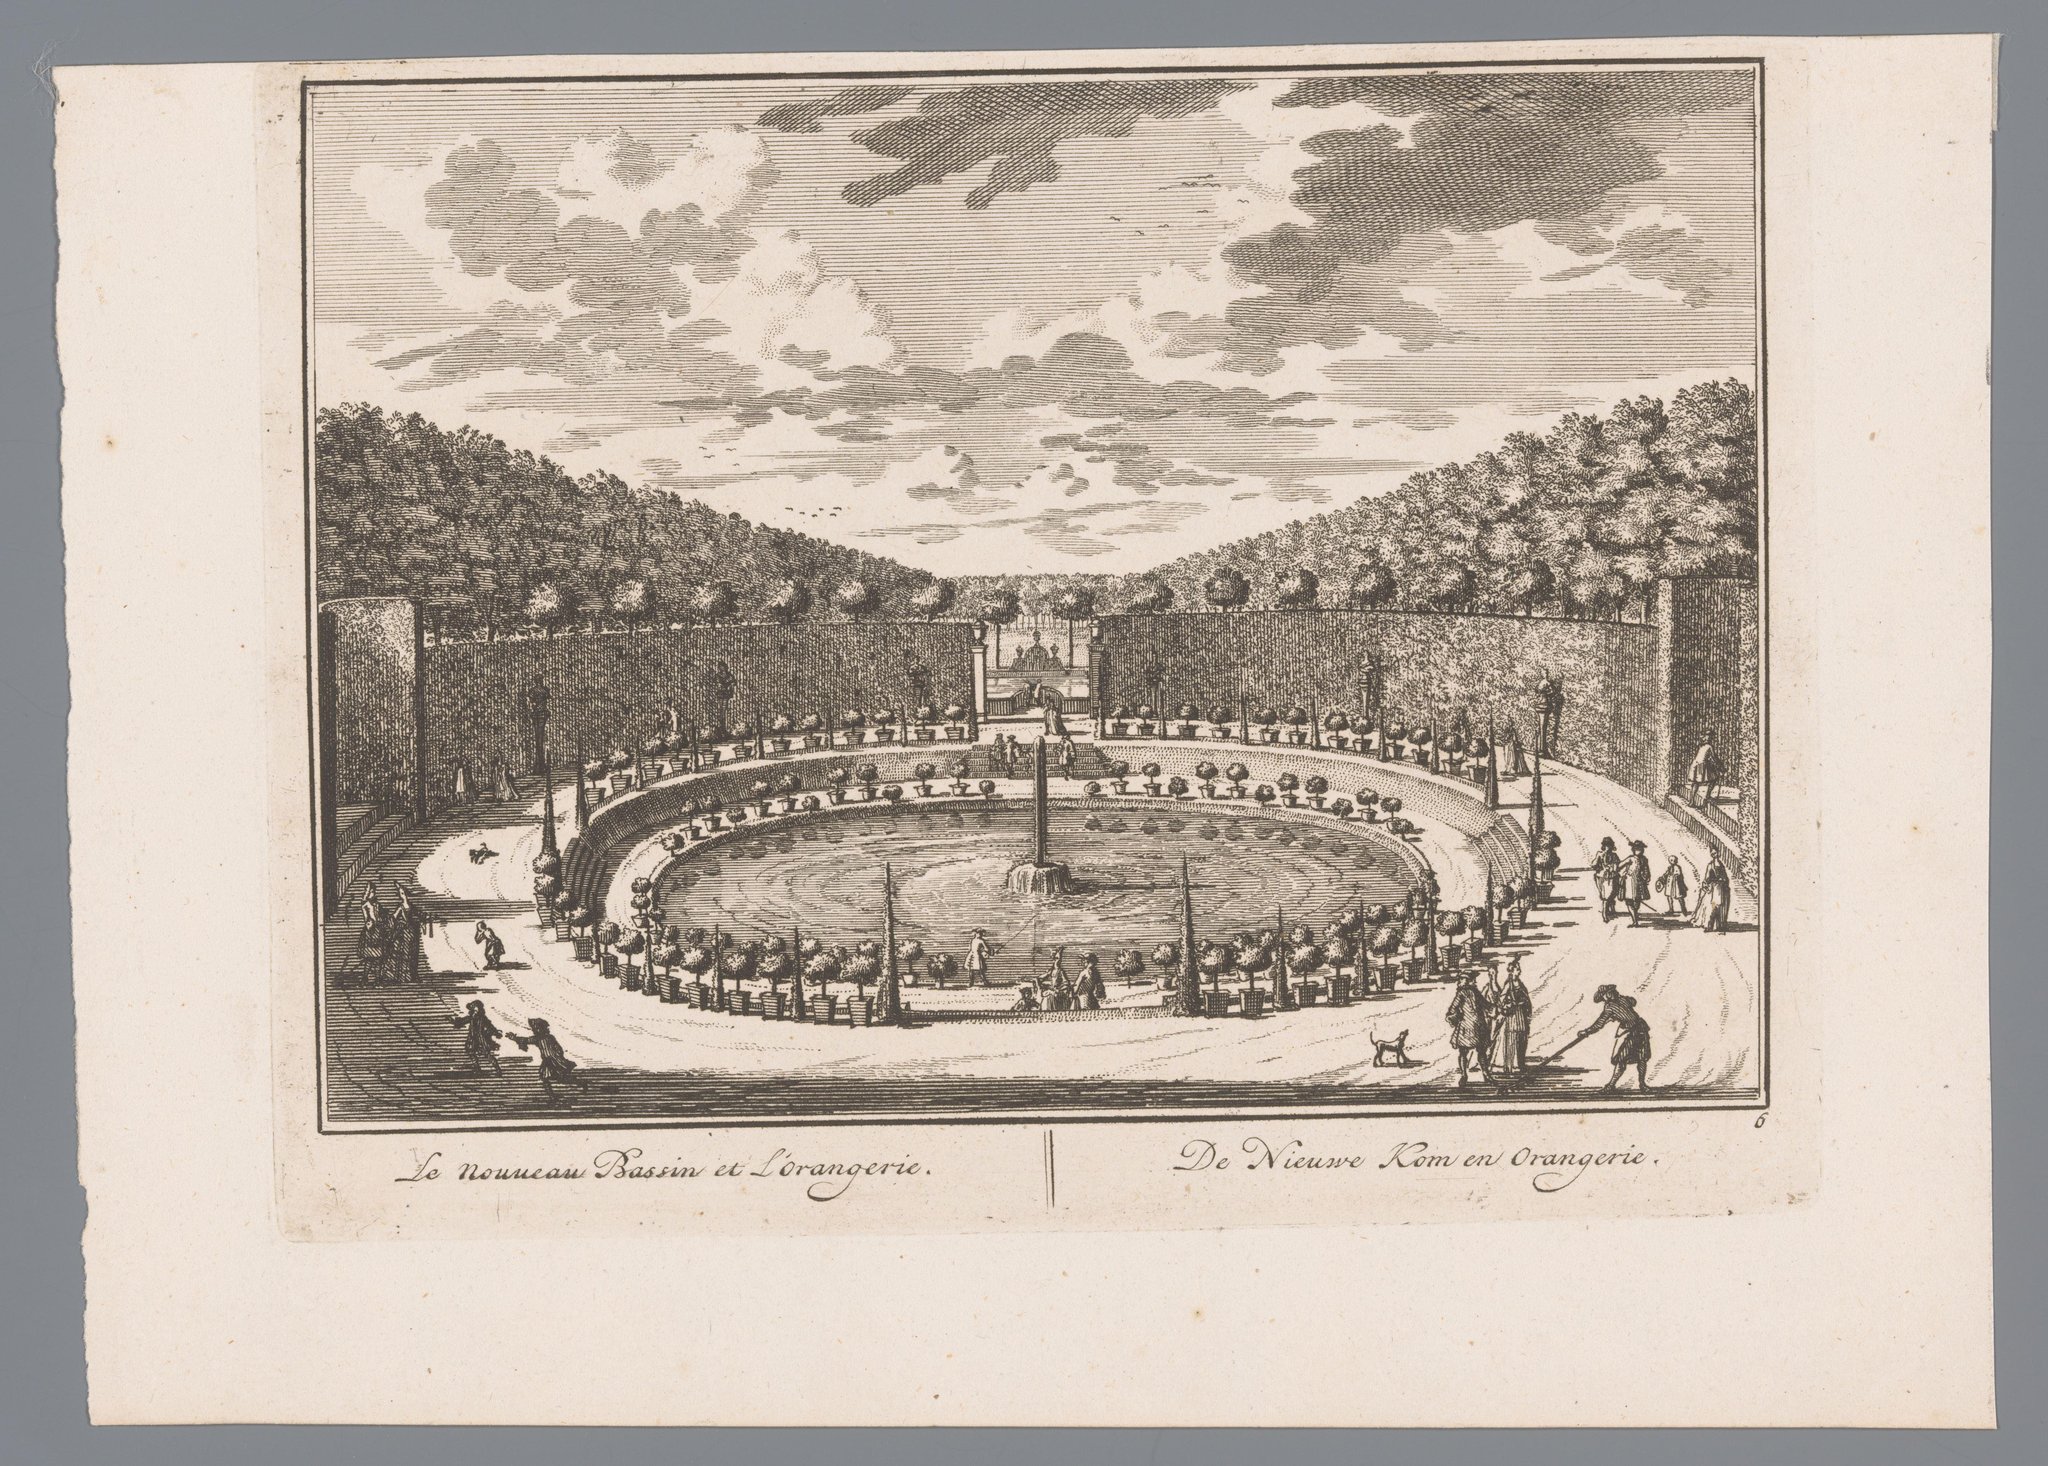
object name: print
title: Le nouveau bassen et l'orangerie / De nieuwe kom en orangerie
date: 1682-1726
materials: paper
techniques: etching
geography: amsterdam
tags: castle, landscape with tower or castle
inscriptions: collector's mark: Lugt 2233